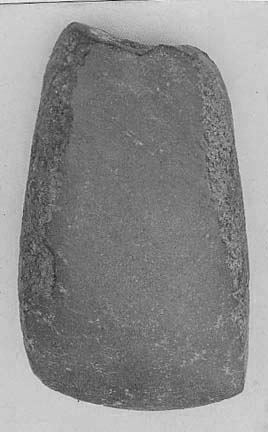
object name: hatchet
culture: german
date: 1902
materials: jade